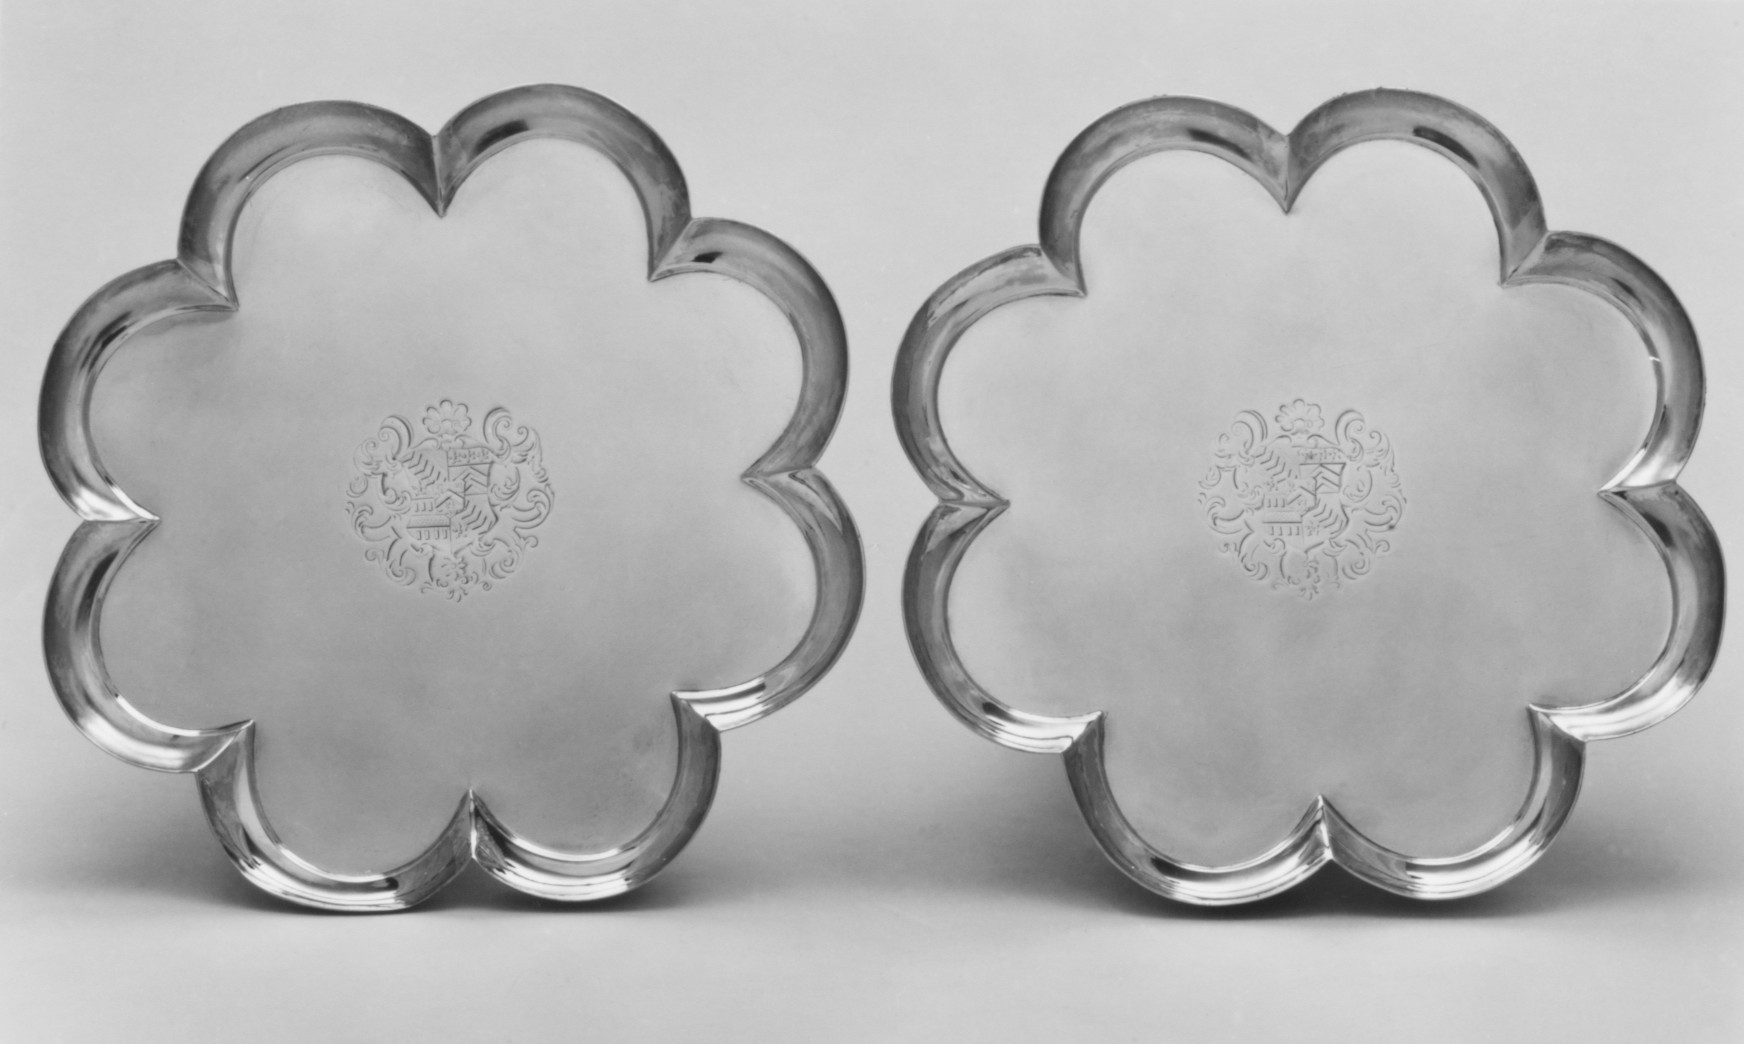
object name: salver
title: Pair of salvers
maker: simon pantin ii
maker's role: maker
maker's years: 1633-1733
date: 1729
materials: silver